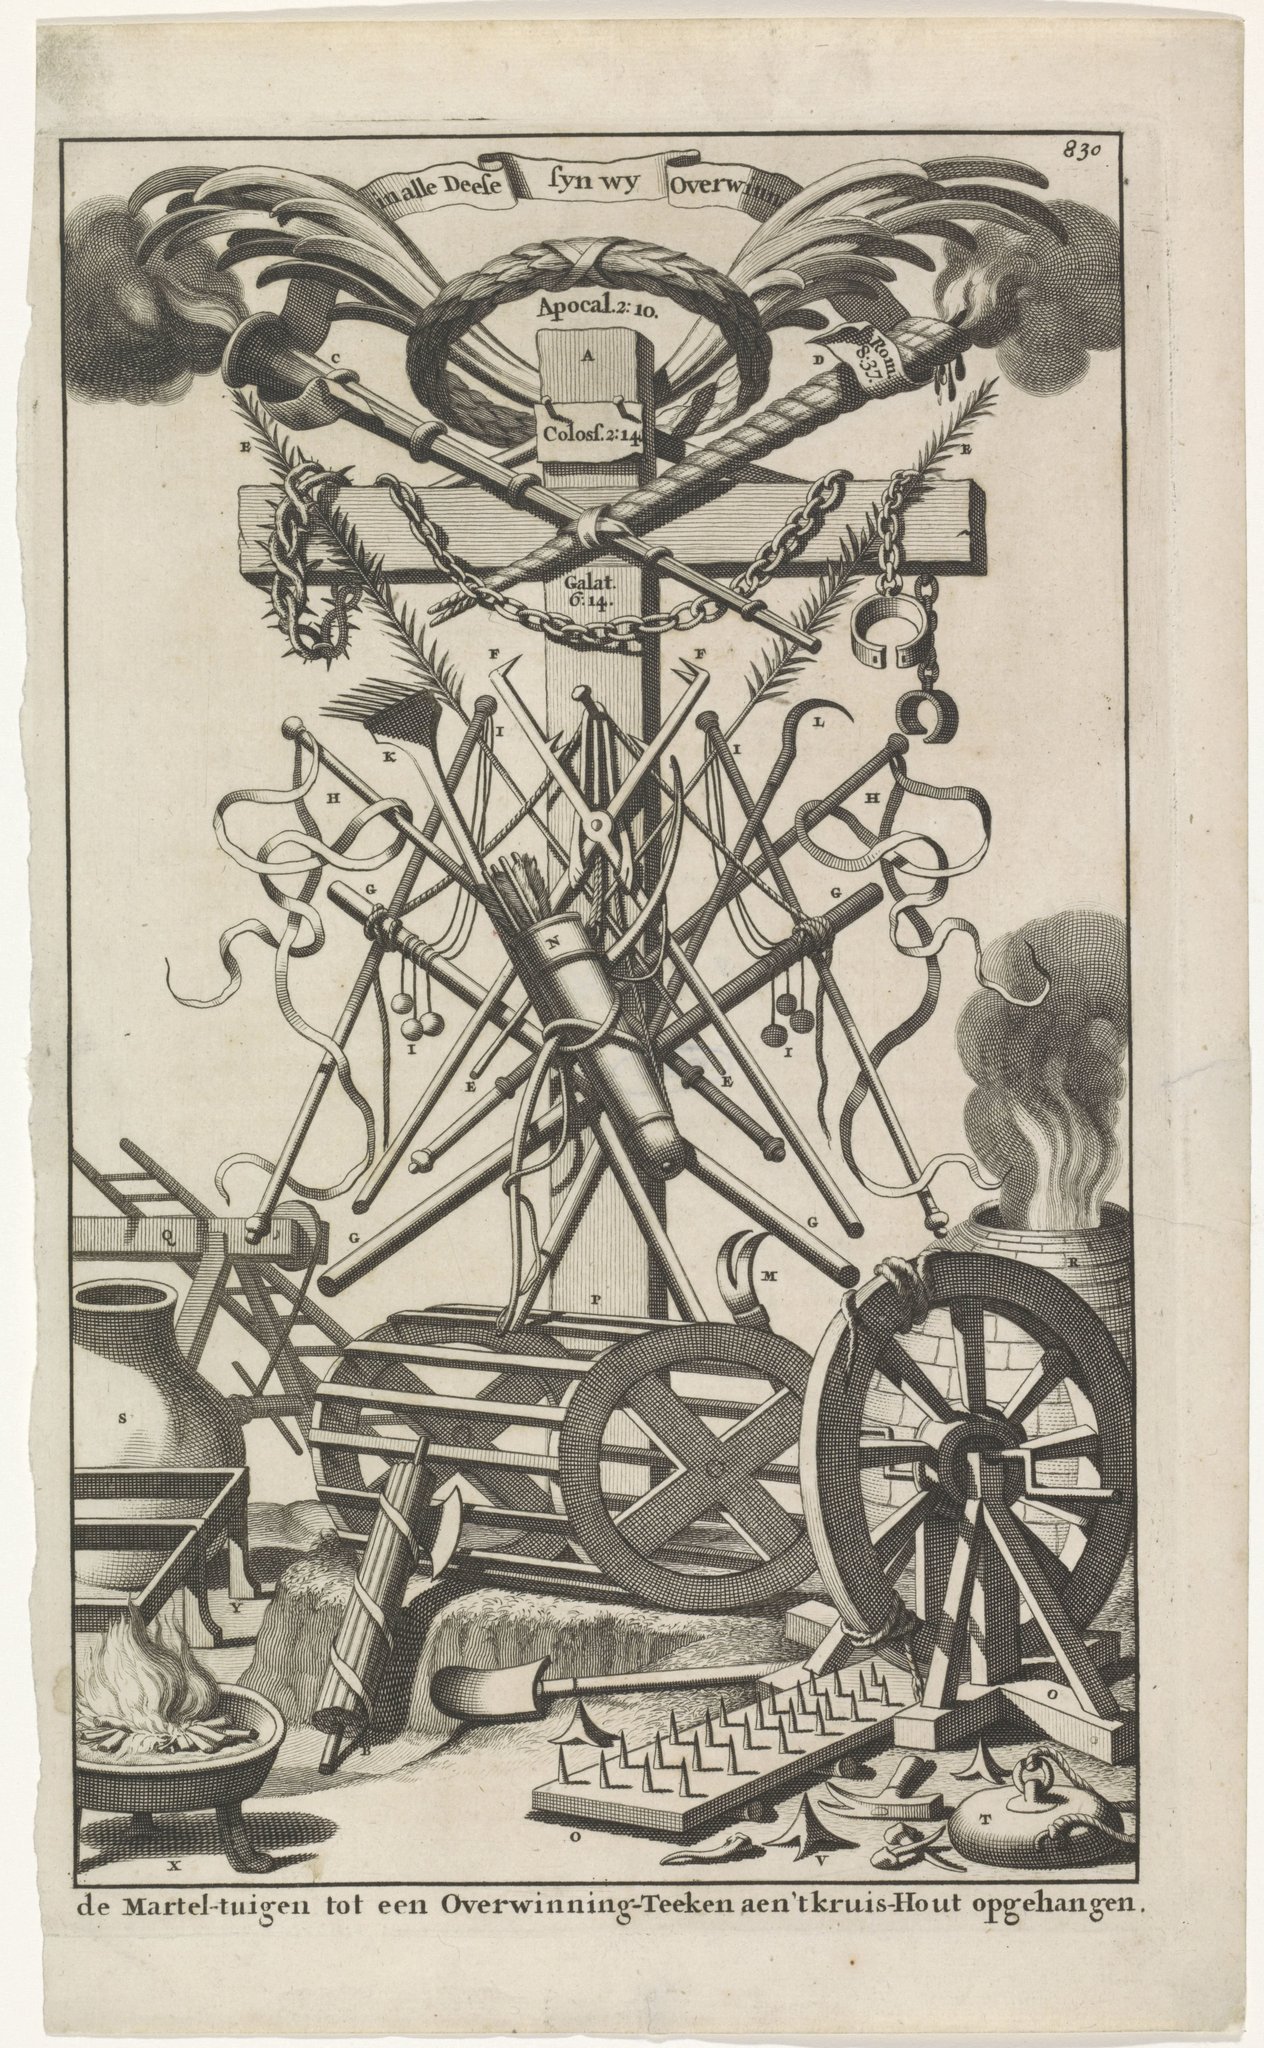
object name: print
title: Martelwerktuigen aan het kruis opgehangen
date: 1690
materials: paper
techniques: engraving, etching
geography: netherlands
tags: instruments of torture, execution or punishment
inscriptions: collector's mark: Lugt 2228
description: Mogelijk gebruikt als boekillustratie in: Goeree, Willem. Voor-bereidselen tot de bybelsche wysheid, en gebruik der heilige en kerklijke historien. 2 delen. Amsterdam: Willem Goeree, 1690.